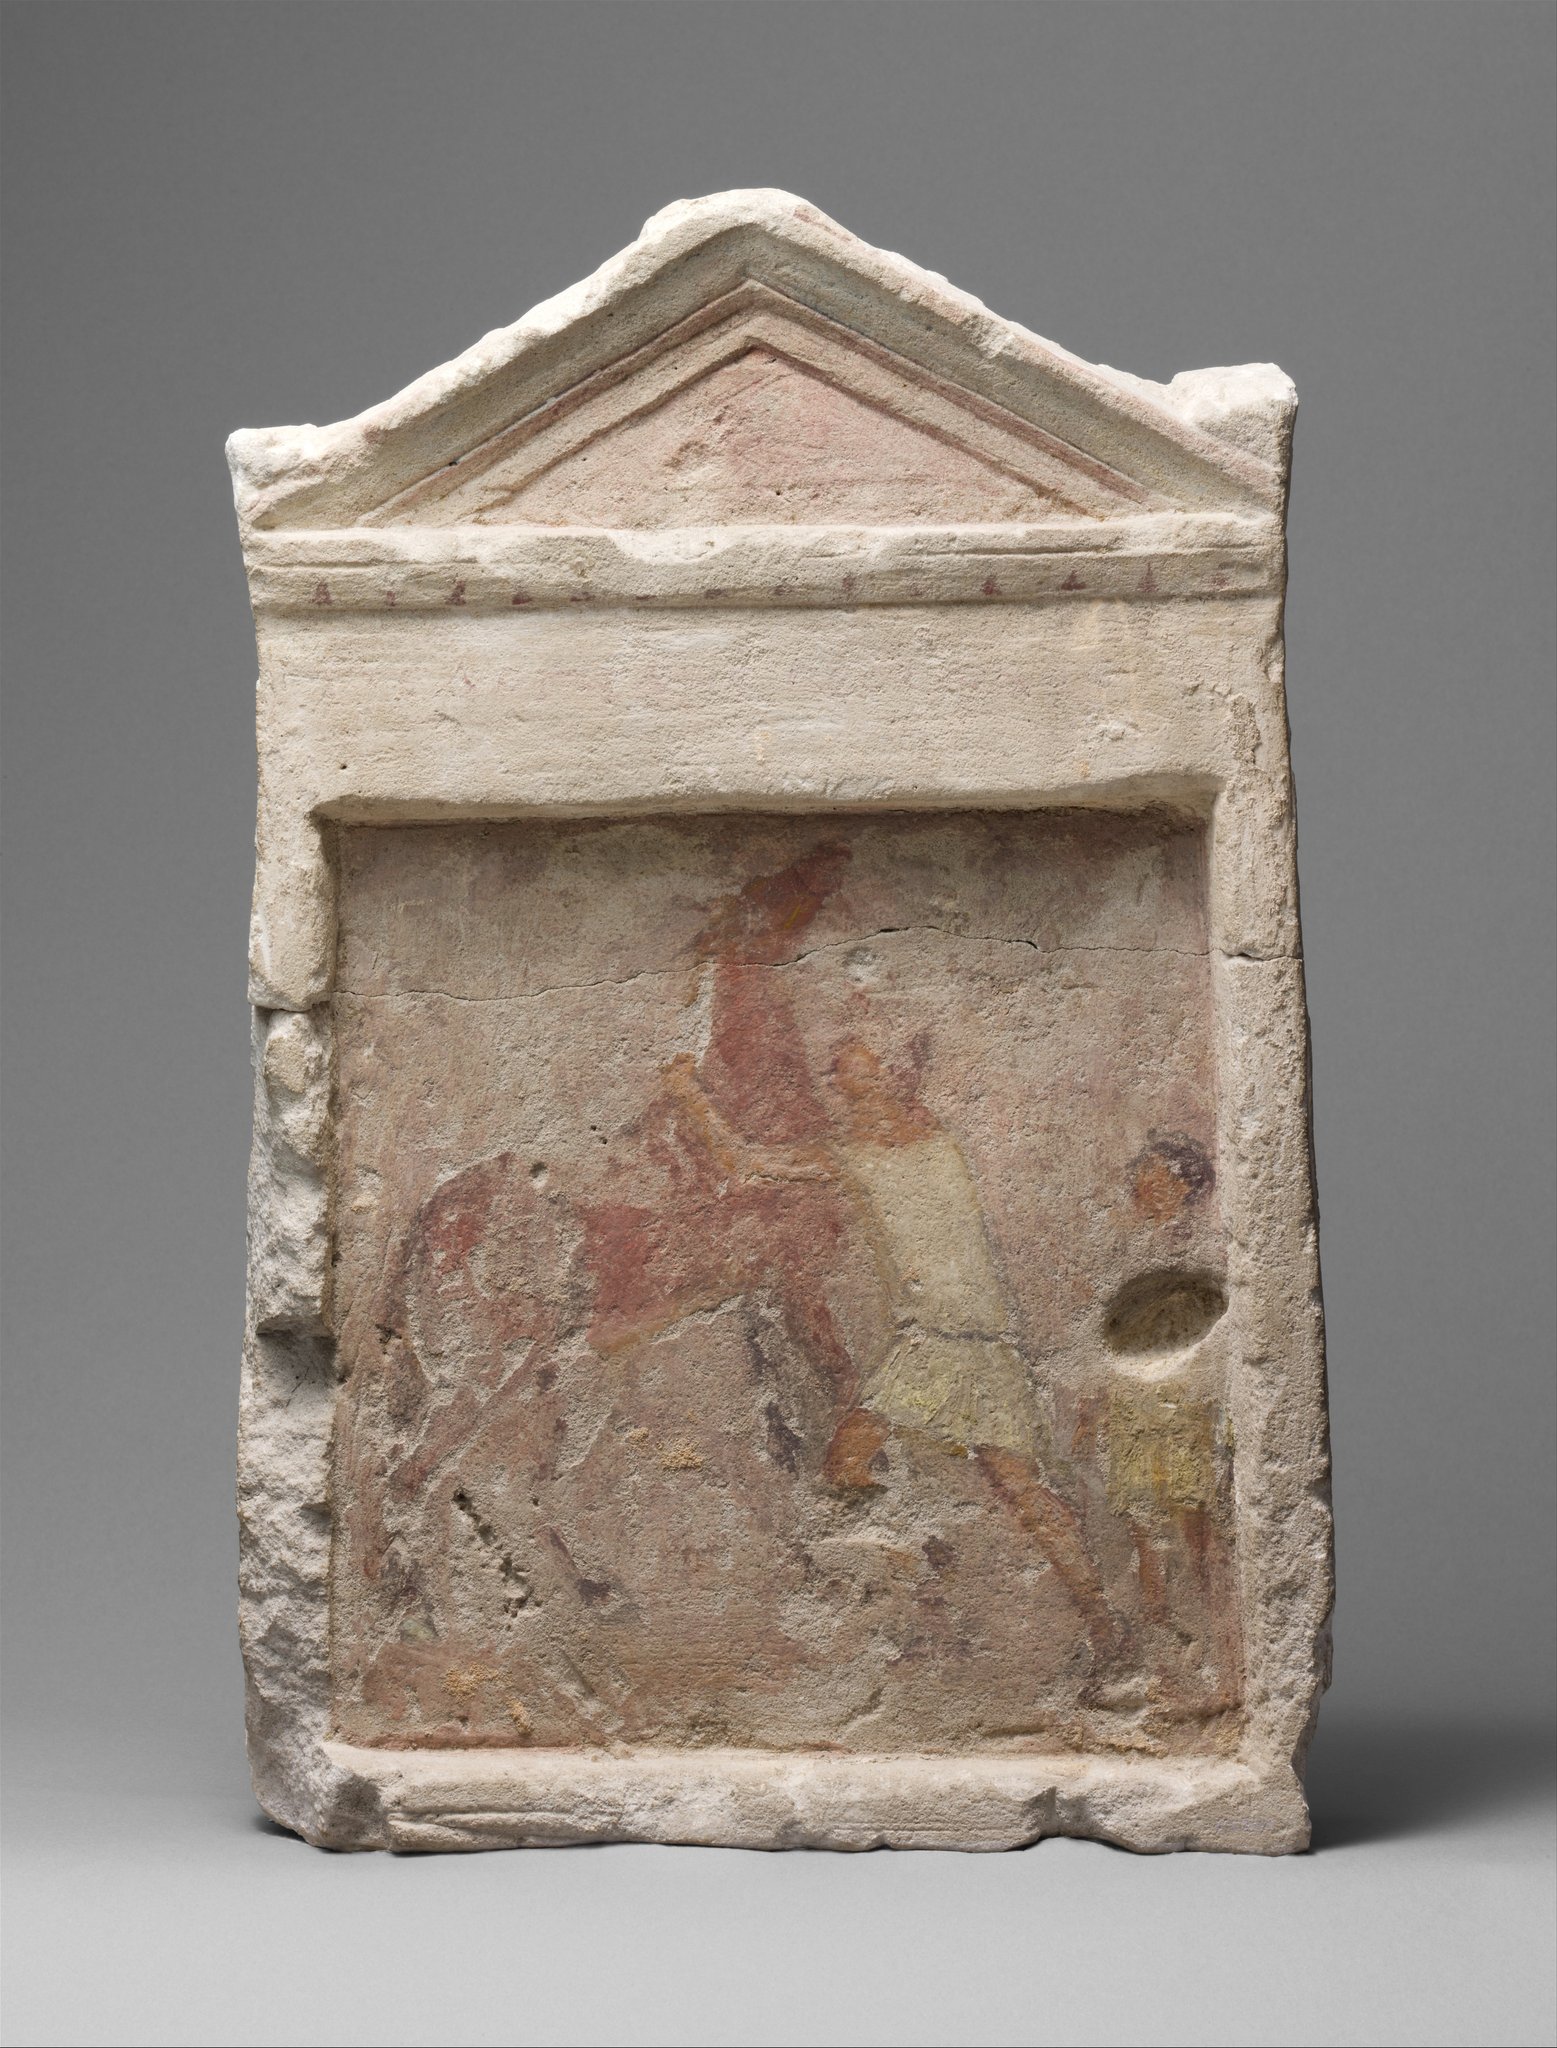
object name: grave stele, painted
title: Painted limestone funerary slab with a man controlling a rearing horse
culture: greek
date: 250-201 BCE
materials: limestone, paint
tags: boys,men,horses